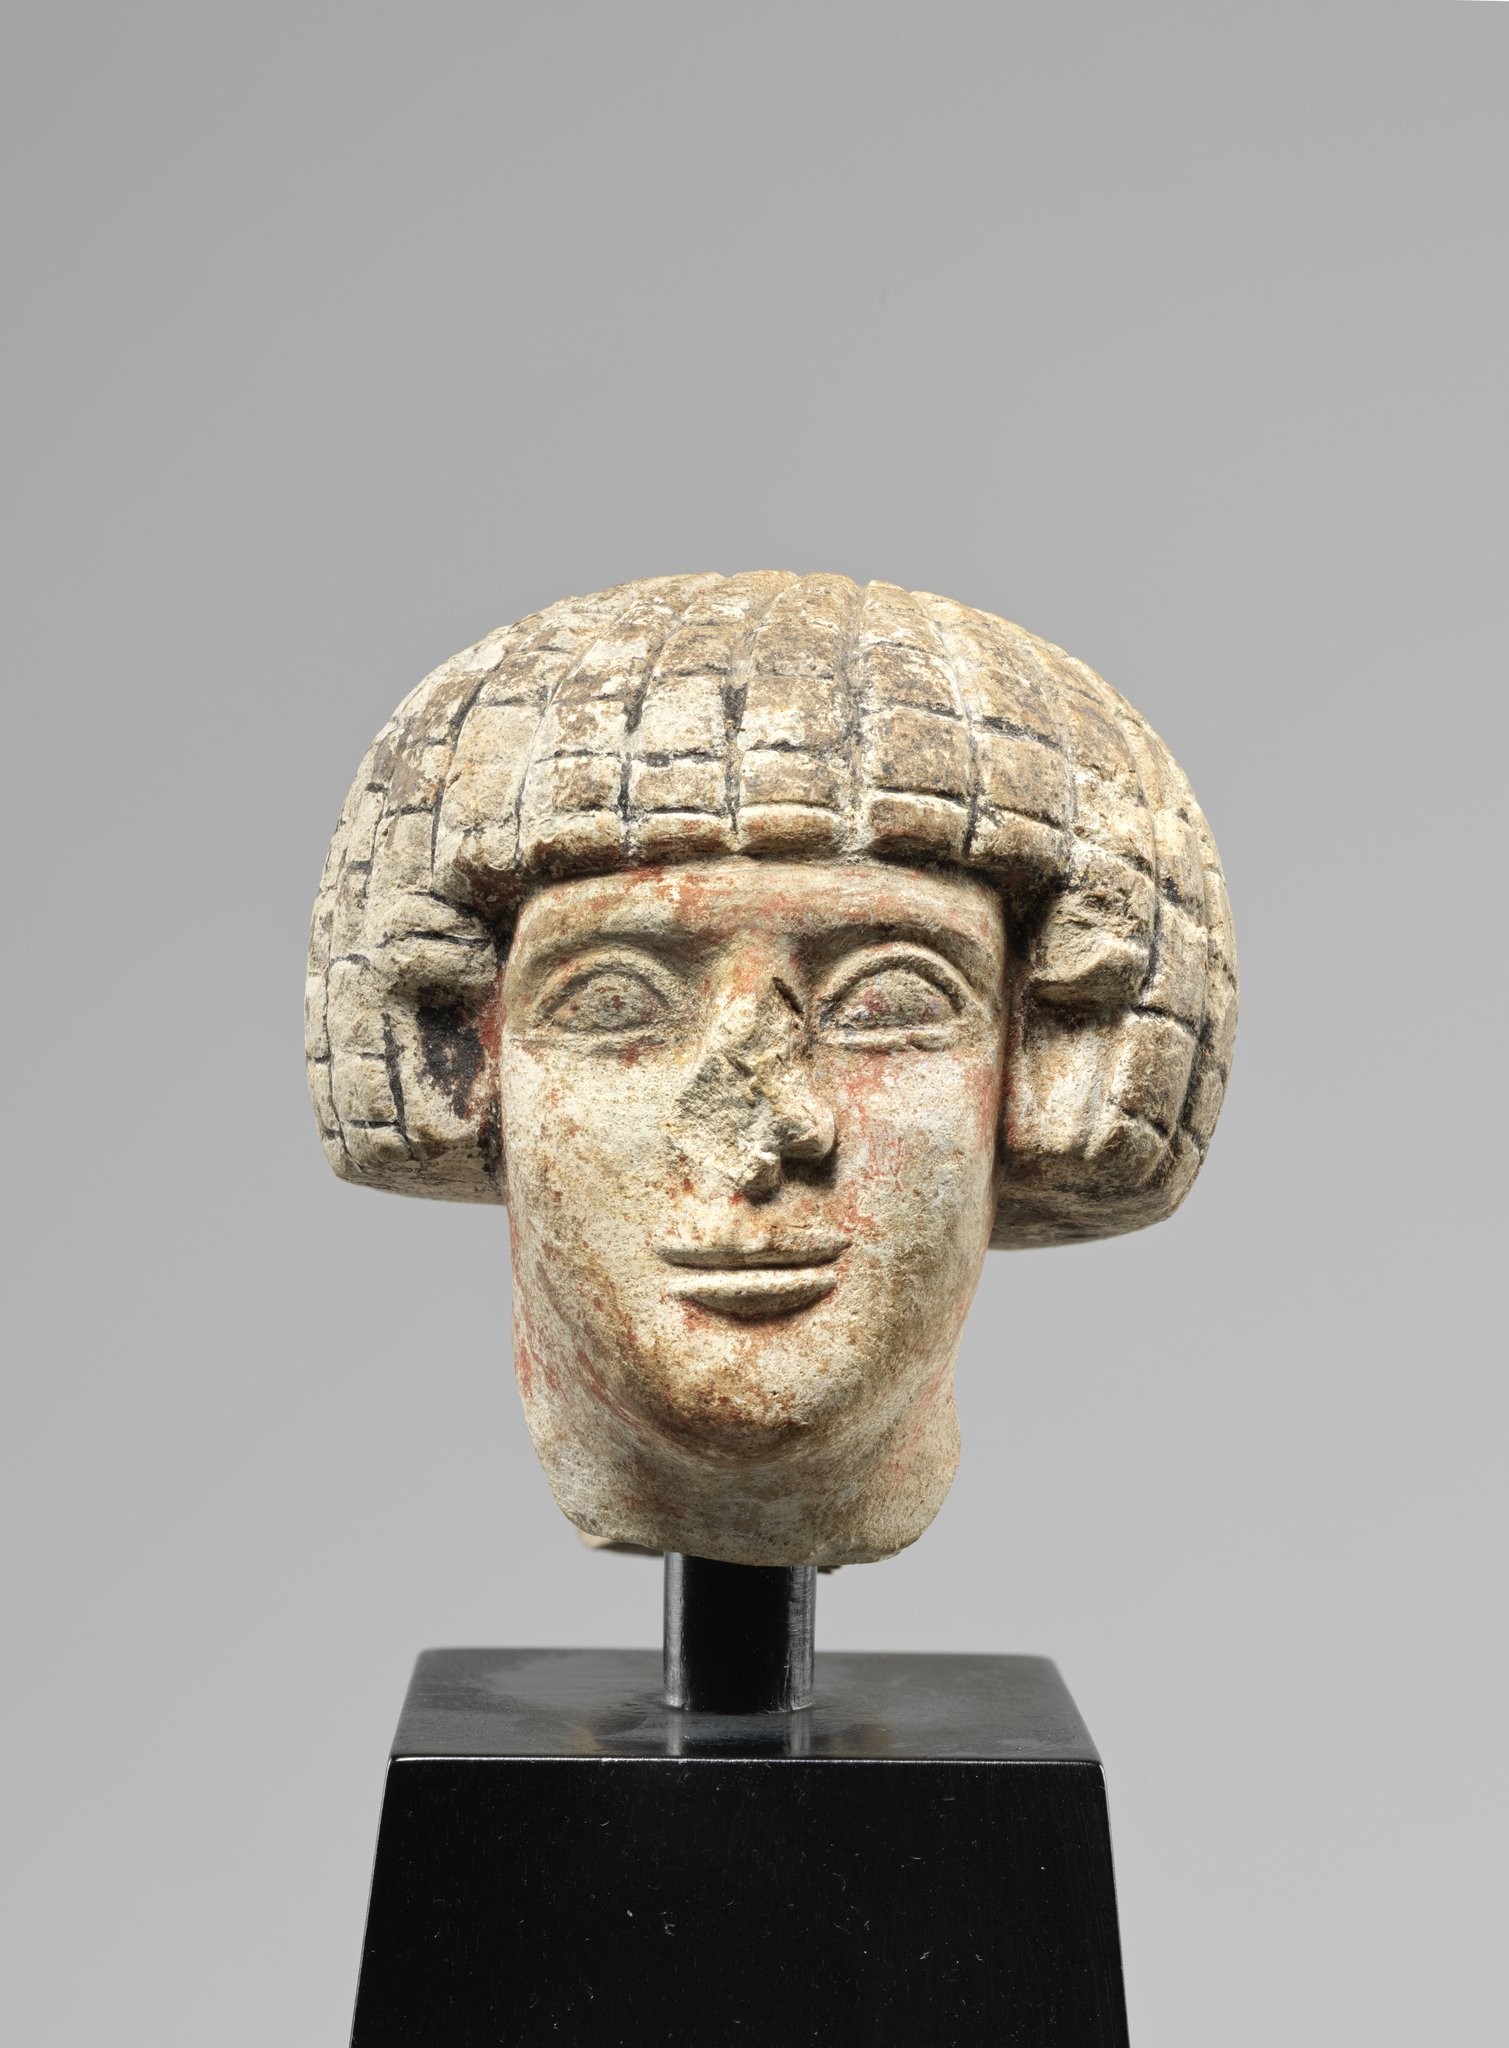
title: Head of a Man with a Round Wig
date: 1625-1500 BCE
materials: limestone, paint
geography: egypt